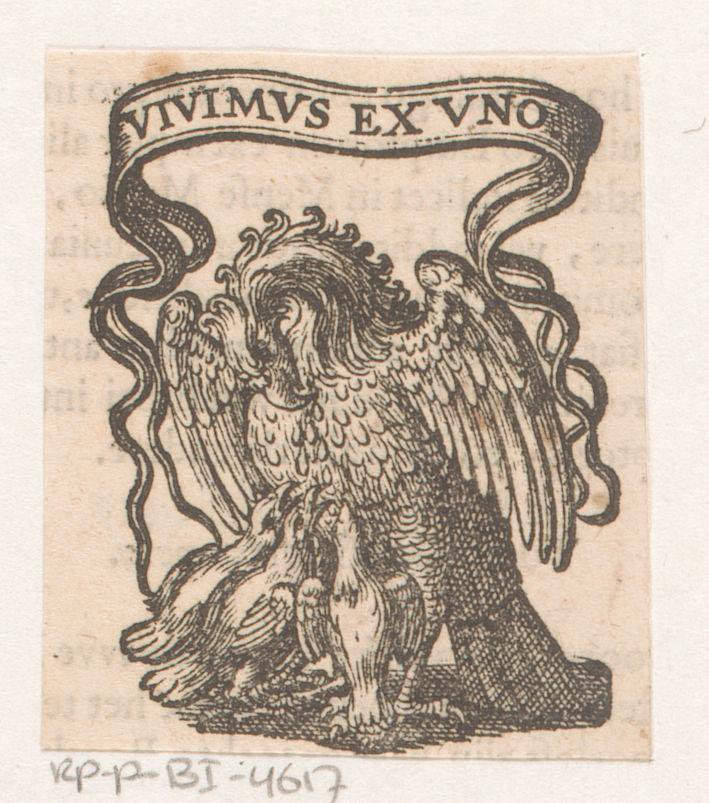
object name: print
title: Vignet met een vogel en drie kuikens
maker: Anonymous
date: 1600-1699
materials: paper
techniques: letterpress printing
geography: netherlands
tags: birds, vignette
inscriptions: collector's mark: Lugt 240